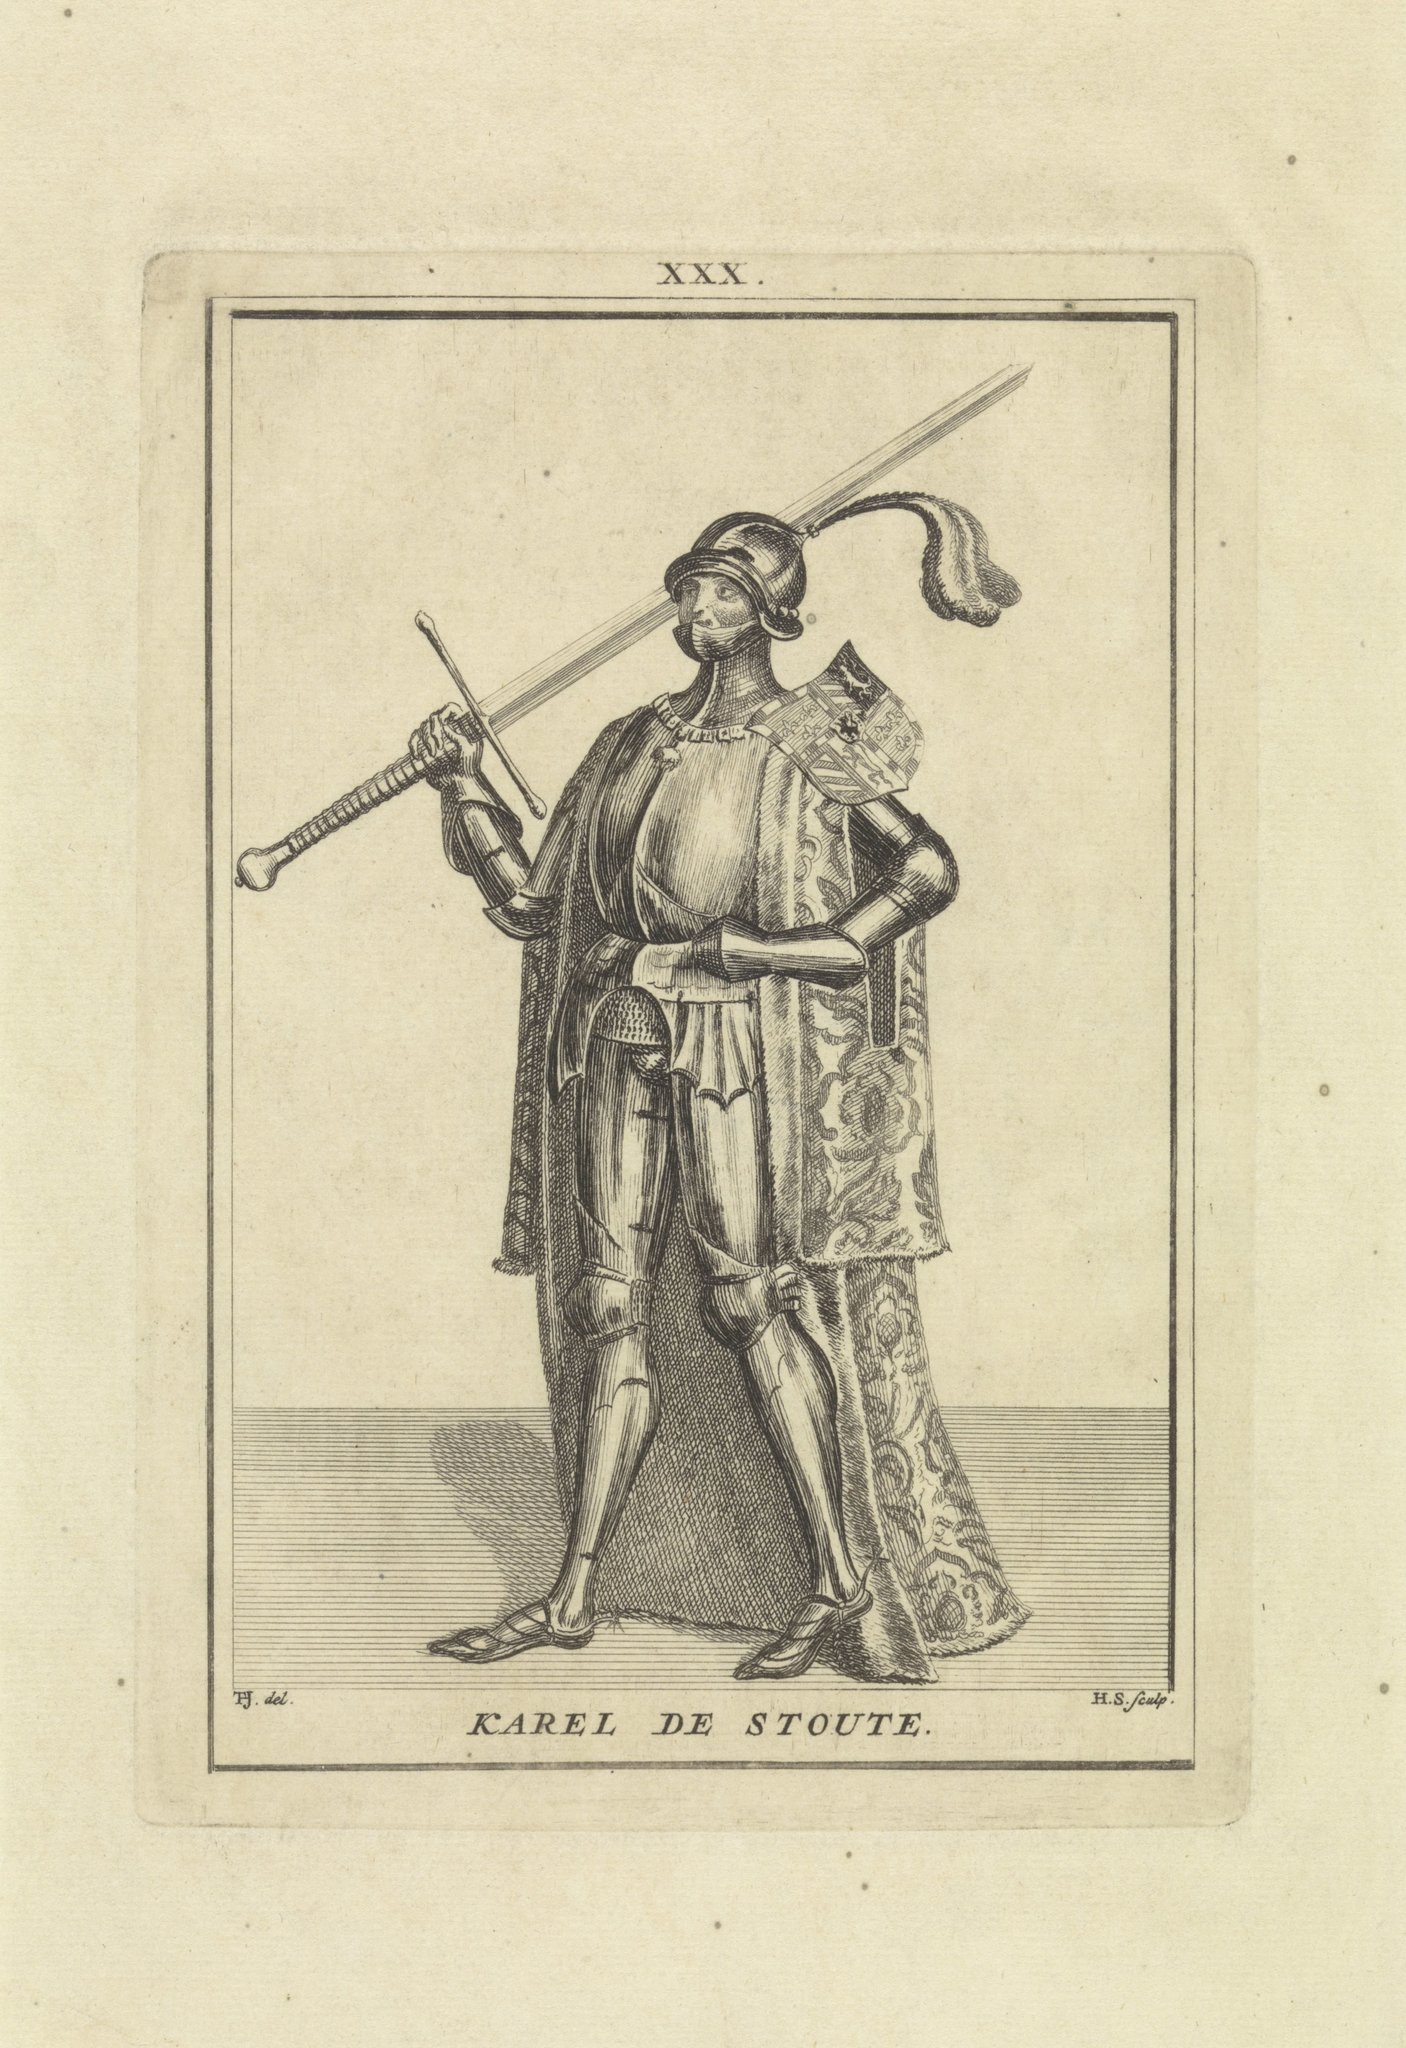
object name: book illustration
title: Portret van Karel de Stoute, hertog van Bourgondië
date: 1745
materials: paper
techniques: etching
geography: haarlem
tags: earl, charles the bold (duke of burgundy), nobility and patriciate; chivalry, knighthood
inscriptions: collector's mark: Lugt 2228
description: Boekillustratie voor: Langendyk, Pieter. De Graaven van Holland, in jaardichten beschreven door Pieter Langendyk. Verykt met alle de beeldtenissen dier prinsen, naauwkeurig getekend naar de echte aloude tafereelen of de zaal van't raadhuis der stad Haarlem. Haarlem: J. Bosch, 1745.